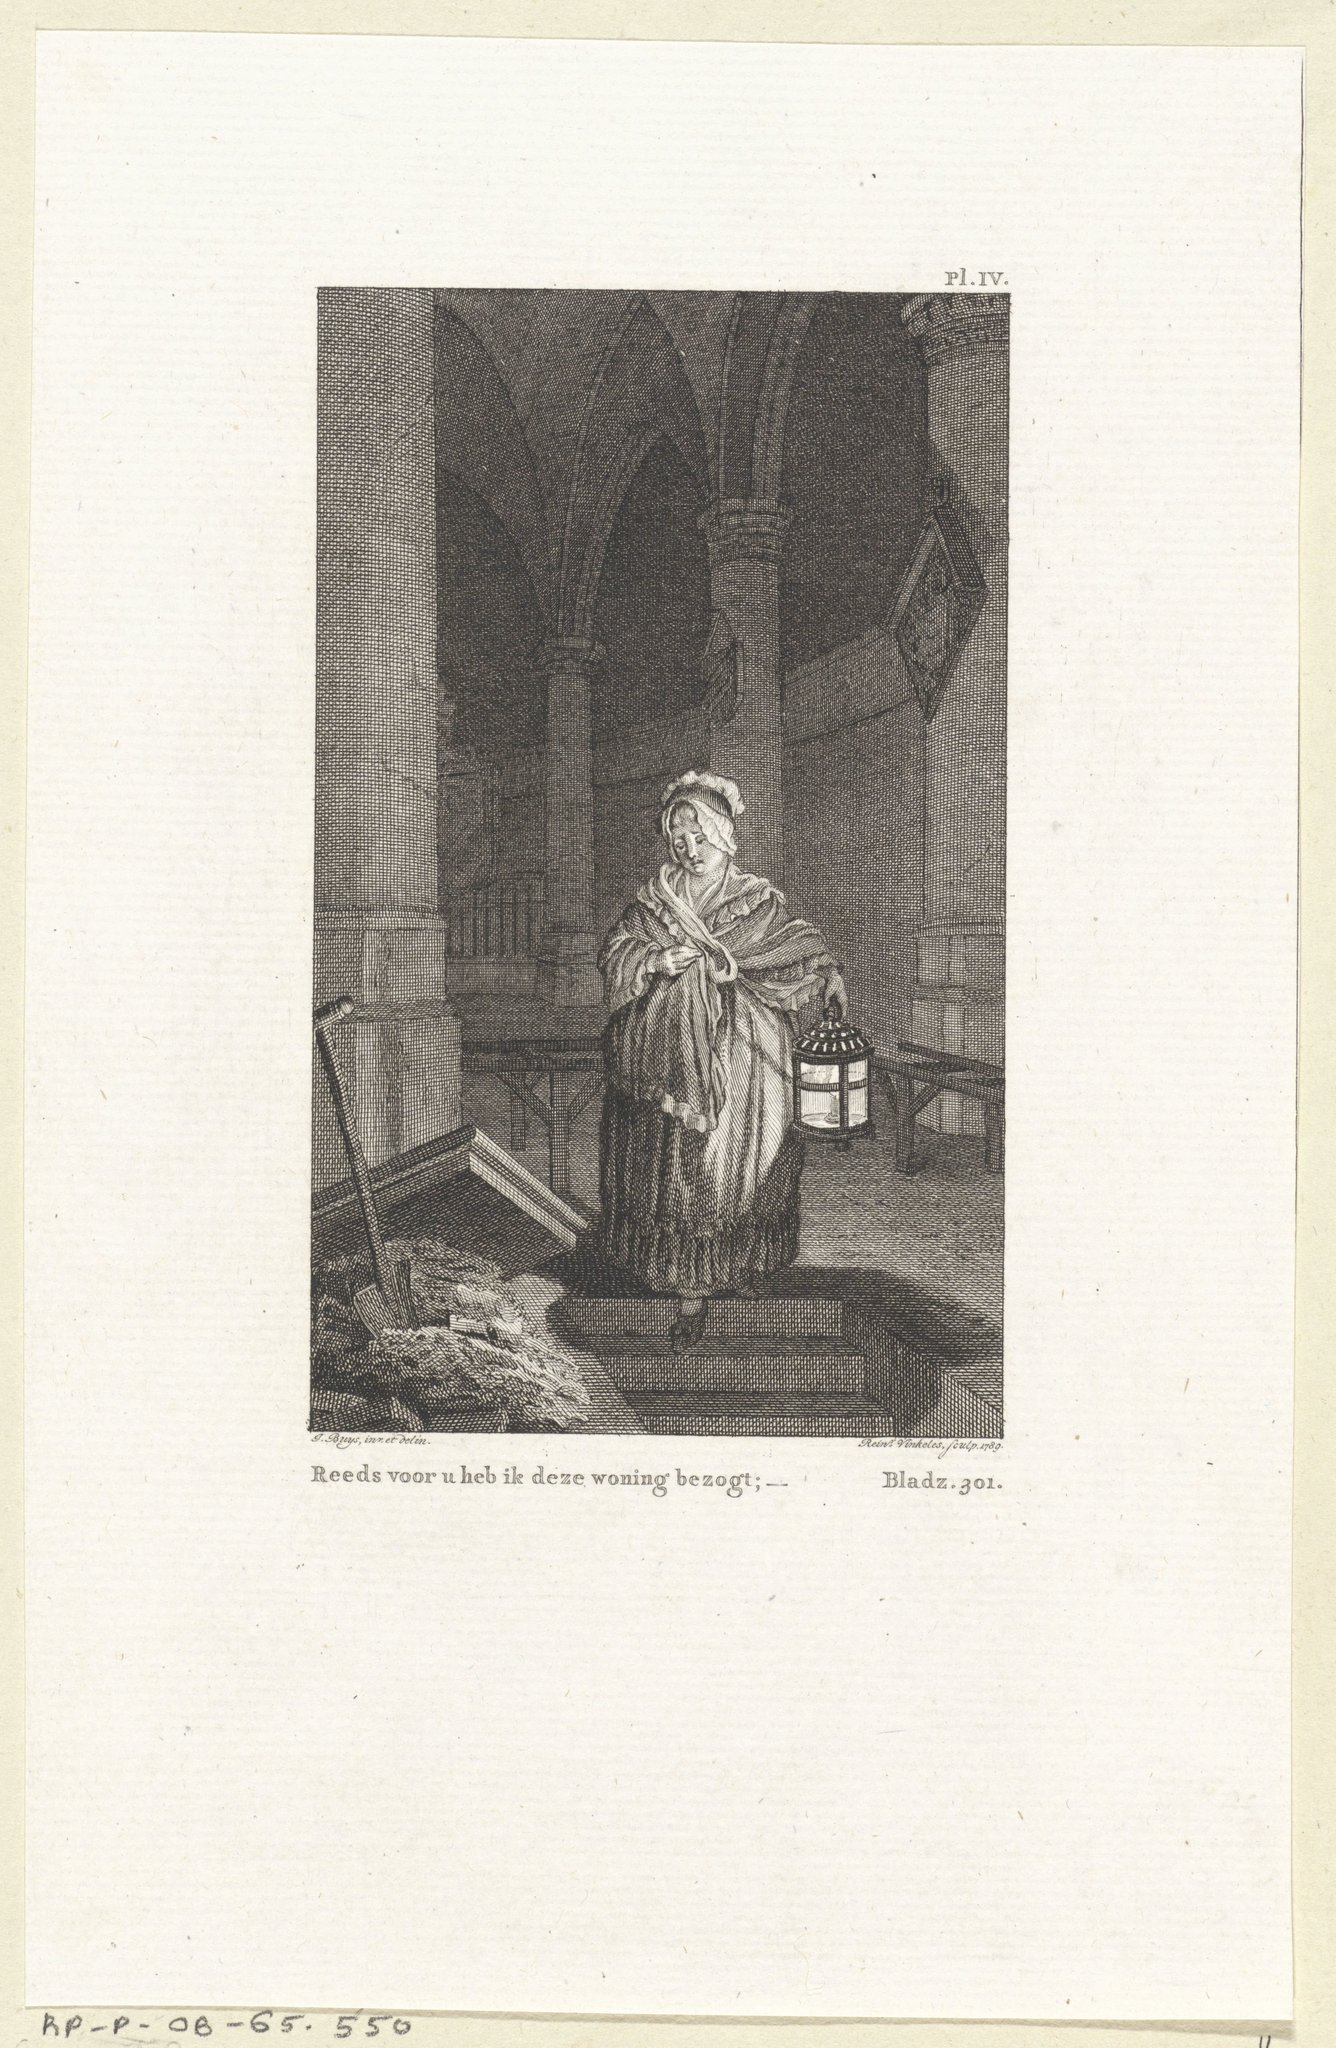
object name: print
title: In een kerk daalt een vrouw af in een graf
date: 1789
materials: paper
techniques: engraving, etching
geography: amsterdam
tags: grave, tomb, interior of church, lantern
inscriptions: collector's mark: Lugt 240